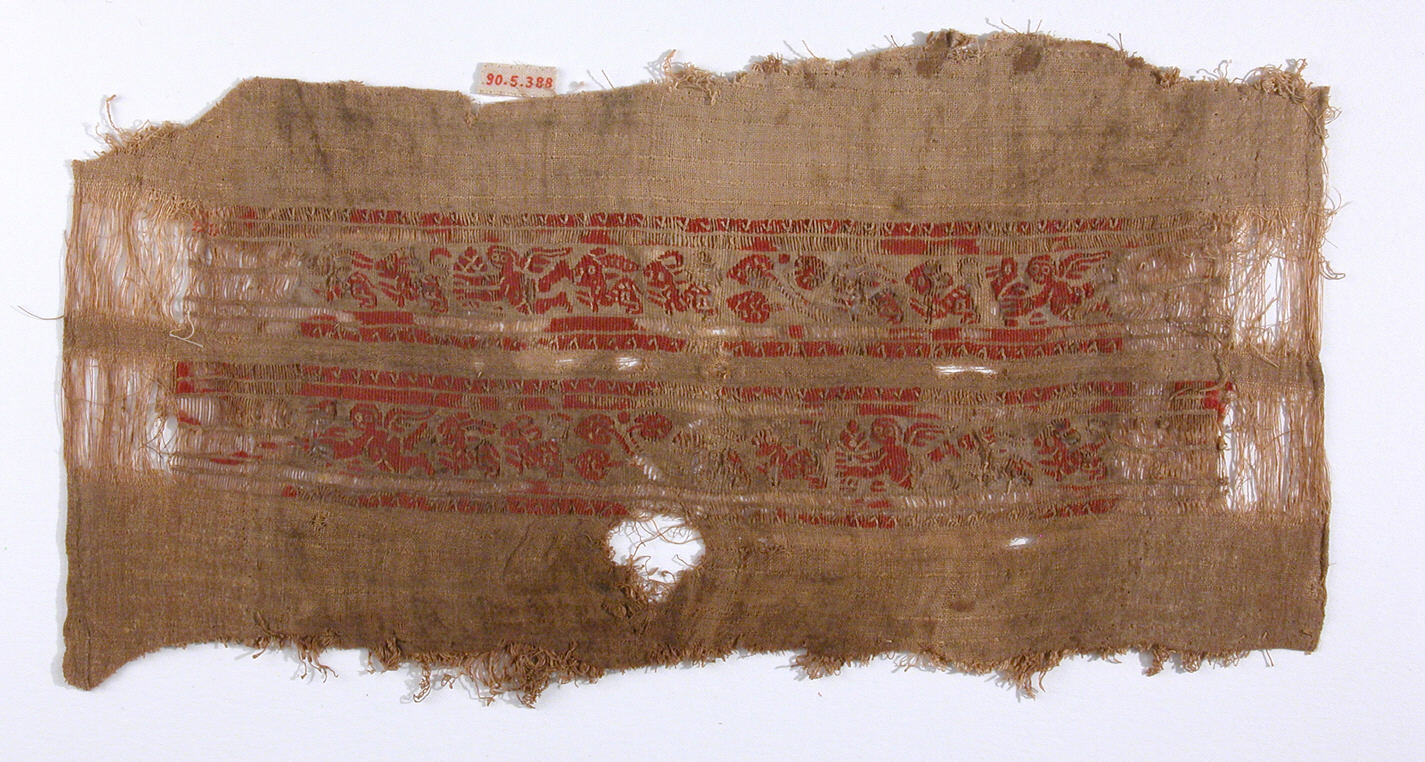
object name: textile fragment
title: Fragment of a Sleeve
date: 301-500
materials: linen, wool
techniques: weave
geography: egypt